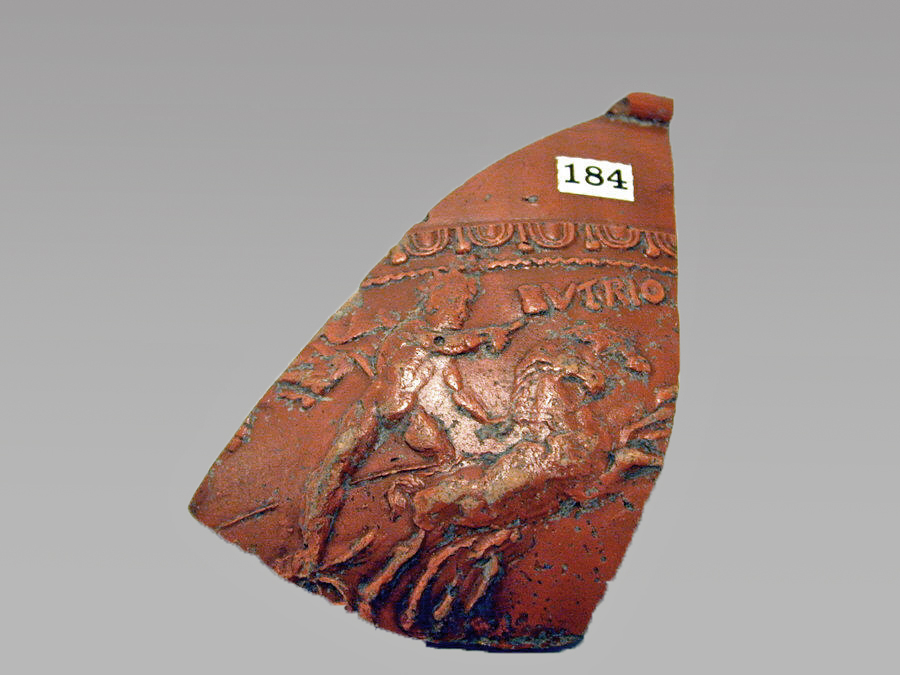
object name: vase fragment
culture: roman, gaul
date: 101-150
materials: terracotta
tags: men,horses